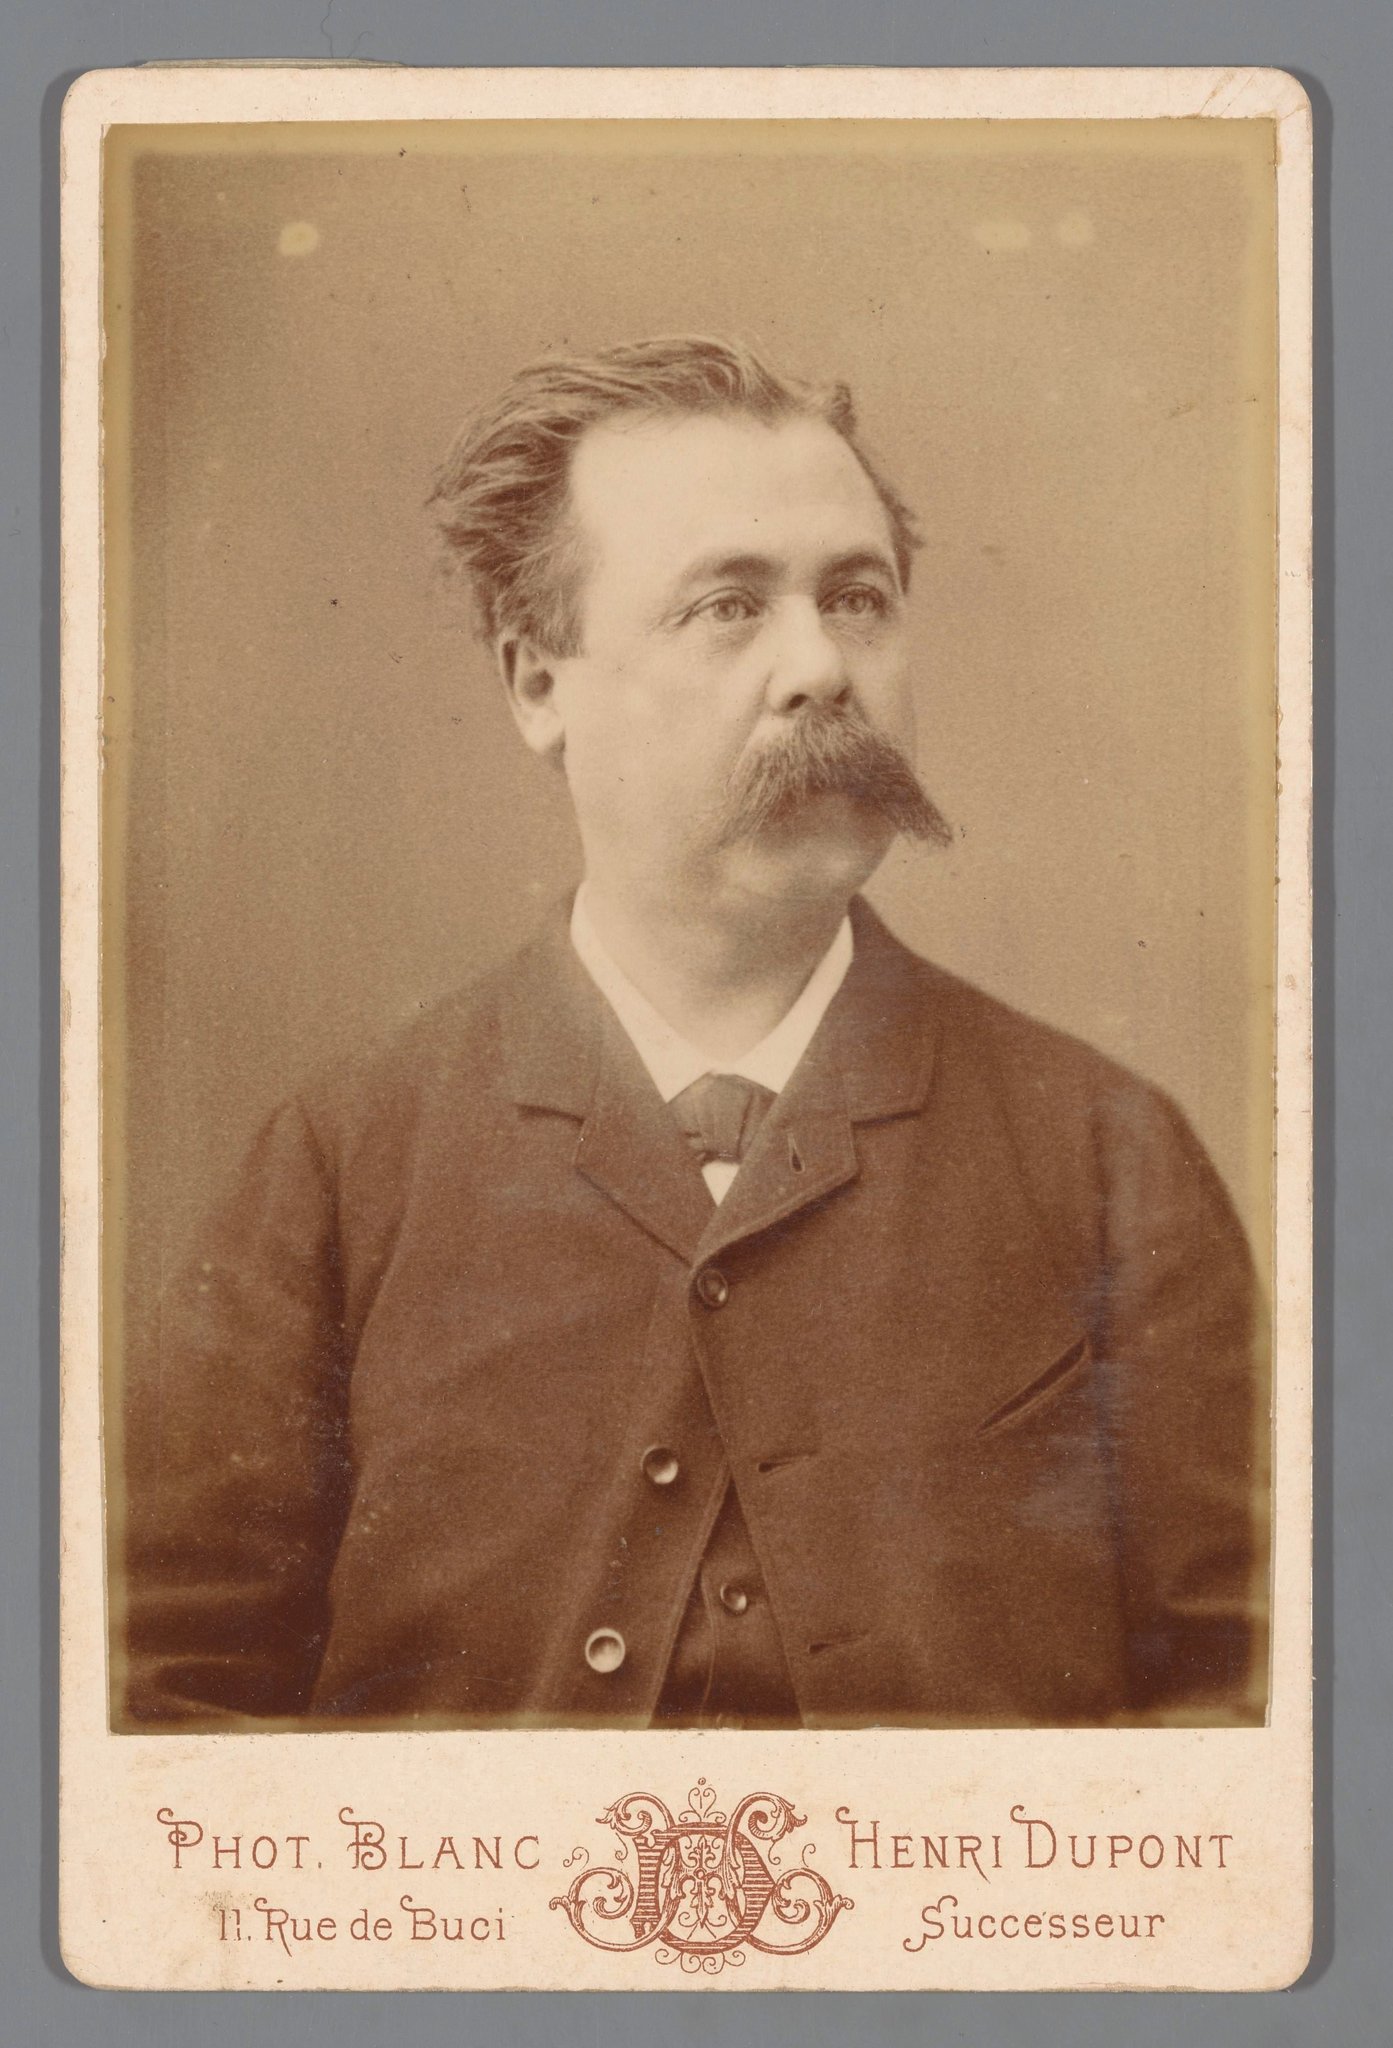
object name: cabinet photograph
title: Portret van een onbekende man met een snor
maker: henri dupont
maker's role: fotograaf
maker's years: 1839-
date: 1880-1890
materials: cardboard, photographic support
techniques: albumen print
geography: paris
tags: moustache, adult man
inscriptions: name: ‘Photographie des Ecoles Maison de 1er Ordre Henri Dupont Rue de Buci No. 11 Paris’